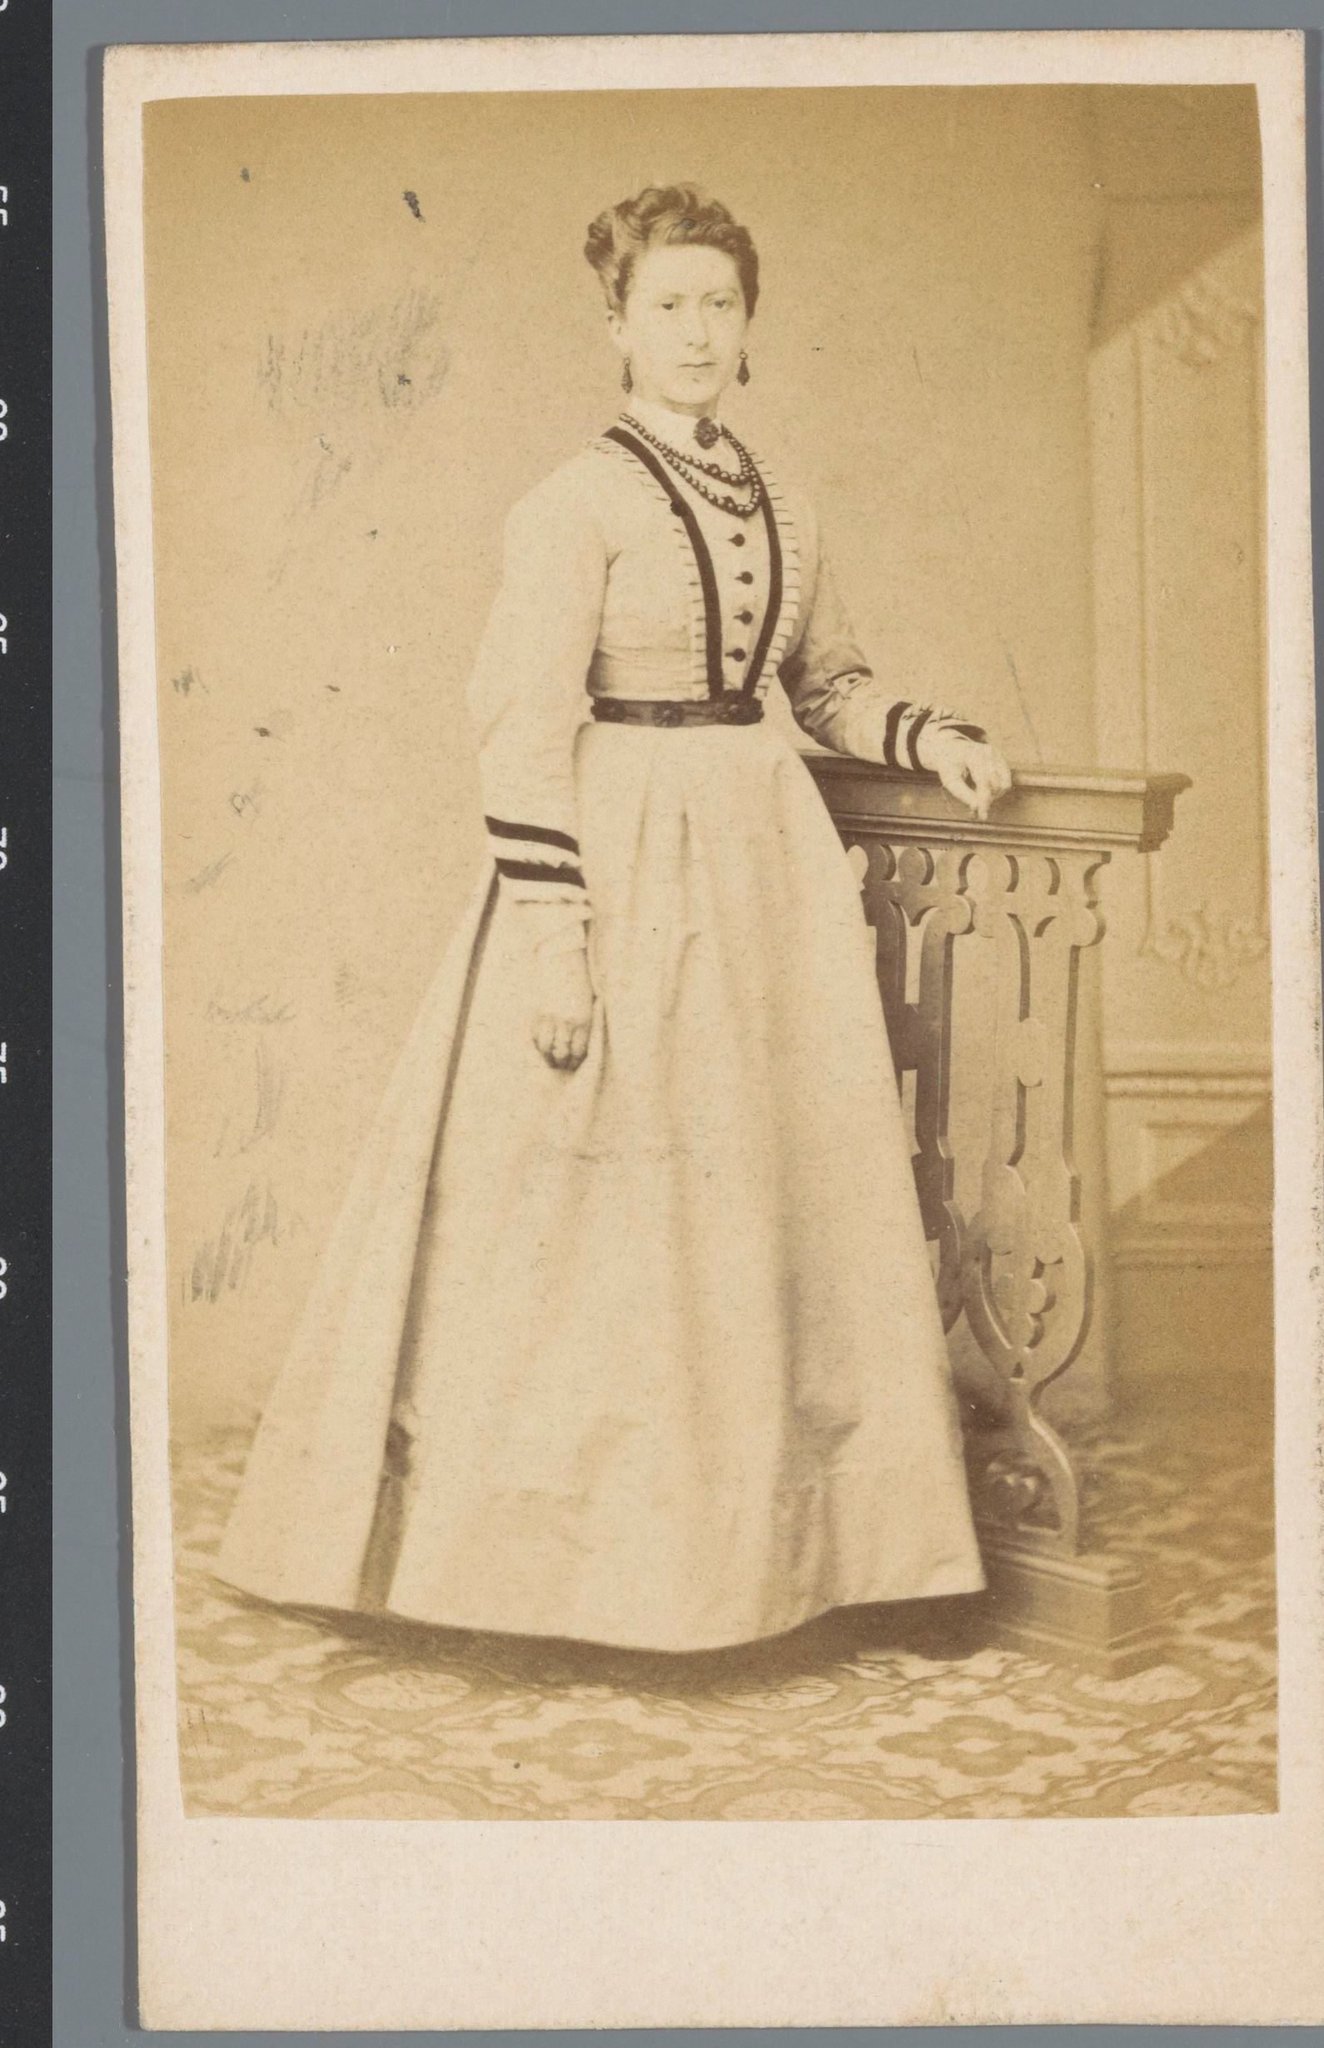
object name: photograph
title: Portret van een onbekende jonge vrouw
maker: anthony martinus hayo polman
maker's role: fotograaf, lithograaf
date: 1866-1878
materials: cardboard, paper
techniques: albumen print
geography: nieuwediep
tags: adolescent, young woman, maiden, anonymous historical person portrayed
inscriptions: inscription: ‘Polman/ Hoofdgracht/ K. 44./ Nieuwe Diep’